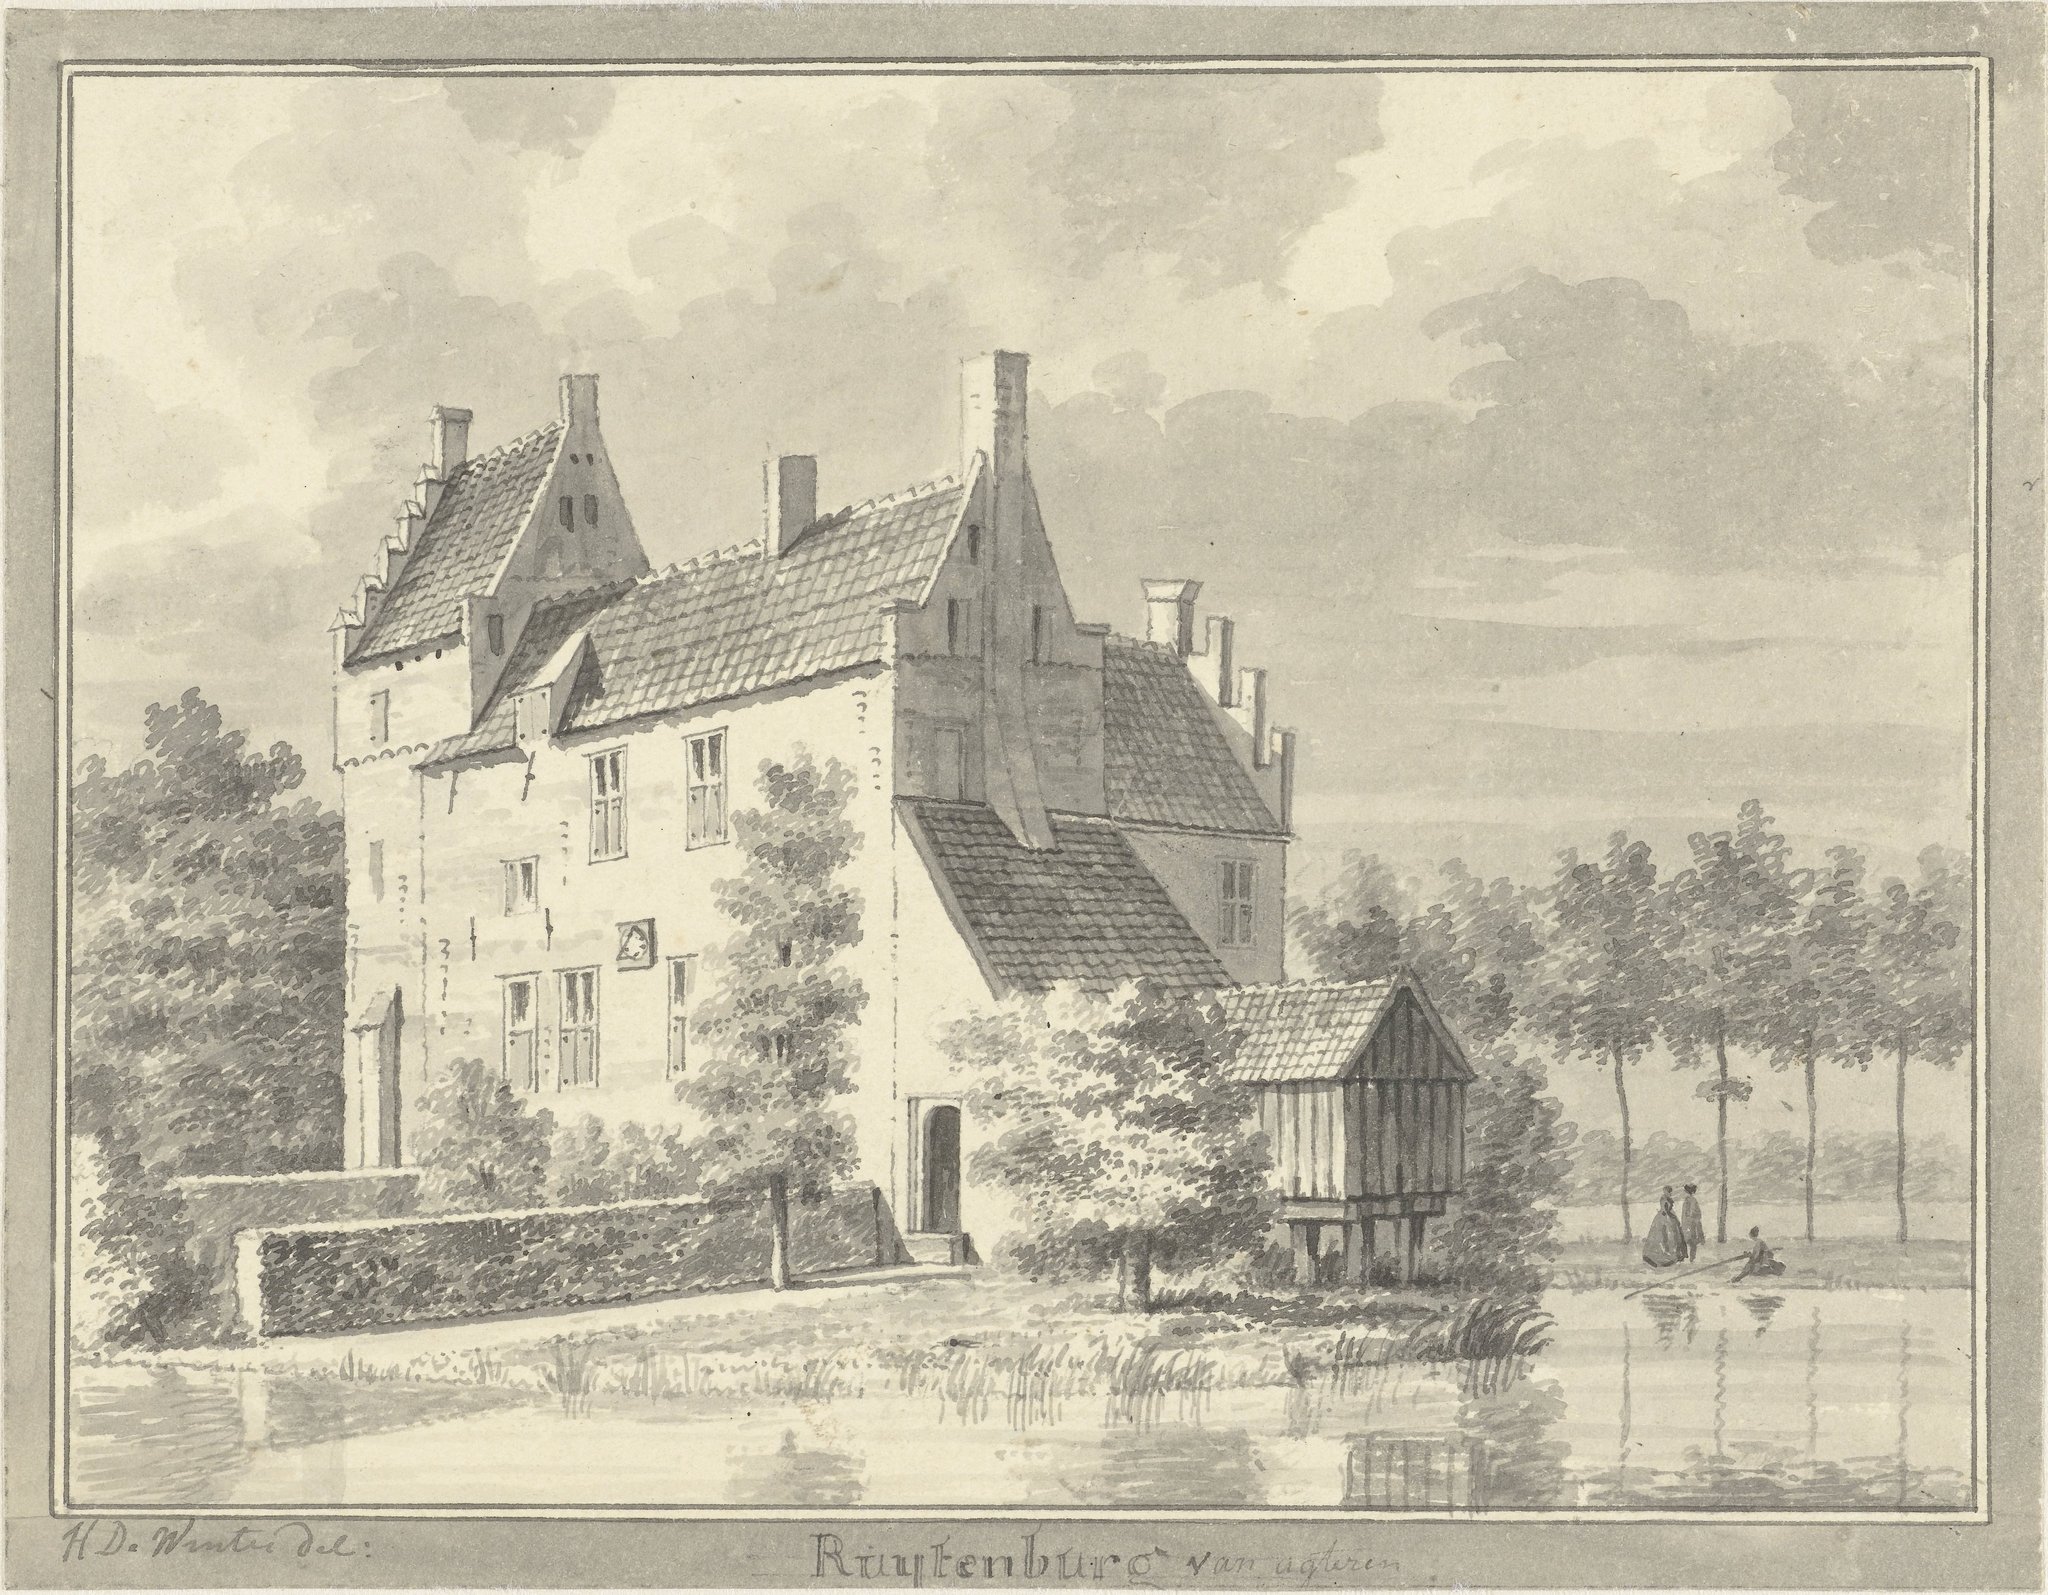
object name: drawing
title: Kasteel Ruytenburg, Overijssel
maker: hendrik de winter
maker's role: draughtsman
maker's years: 1717-1790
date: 1727-1790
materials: ink, paper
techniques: brush, pen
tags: castle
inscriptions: inscription: ‘H De Winter del: Ruytenburg van agteren’